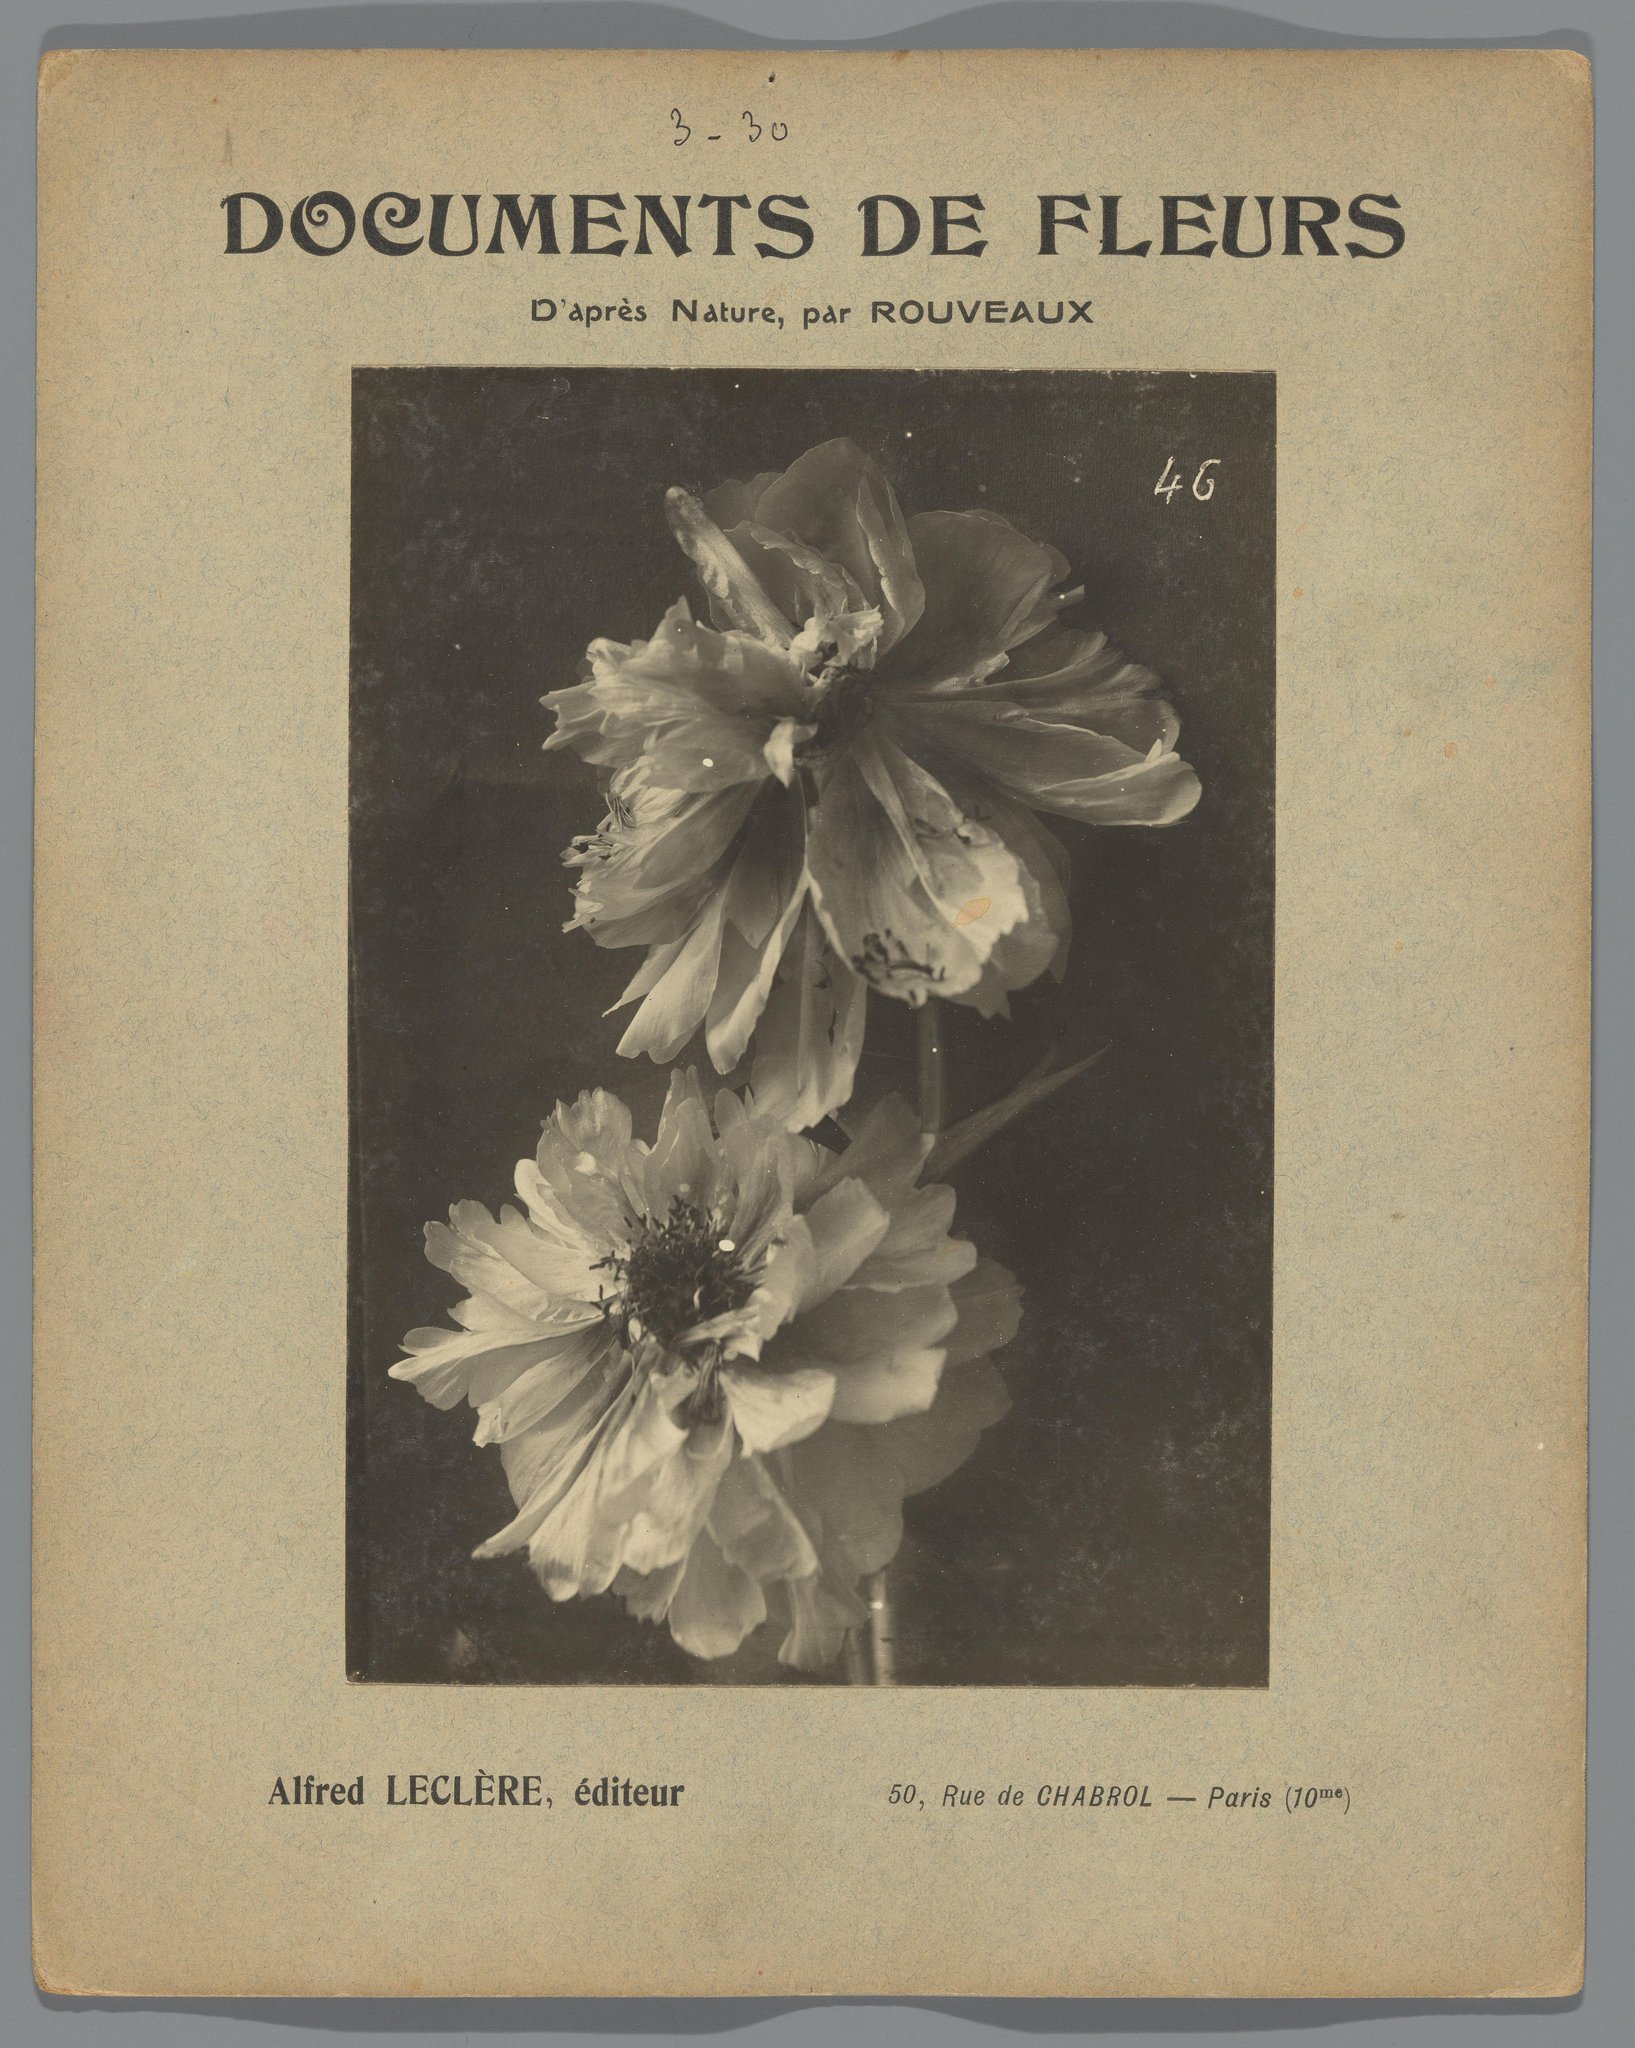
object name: photograph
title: Bloemstudie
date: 1895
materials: photographic support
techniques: gelatin silver print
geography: france